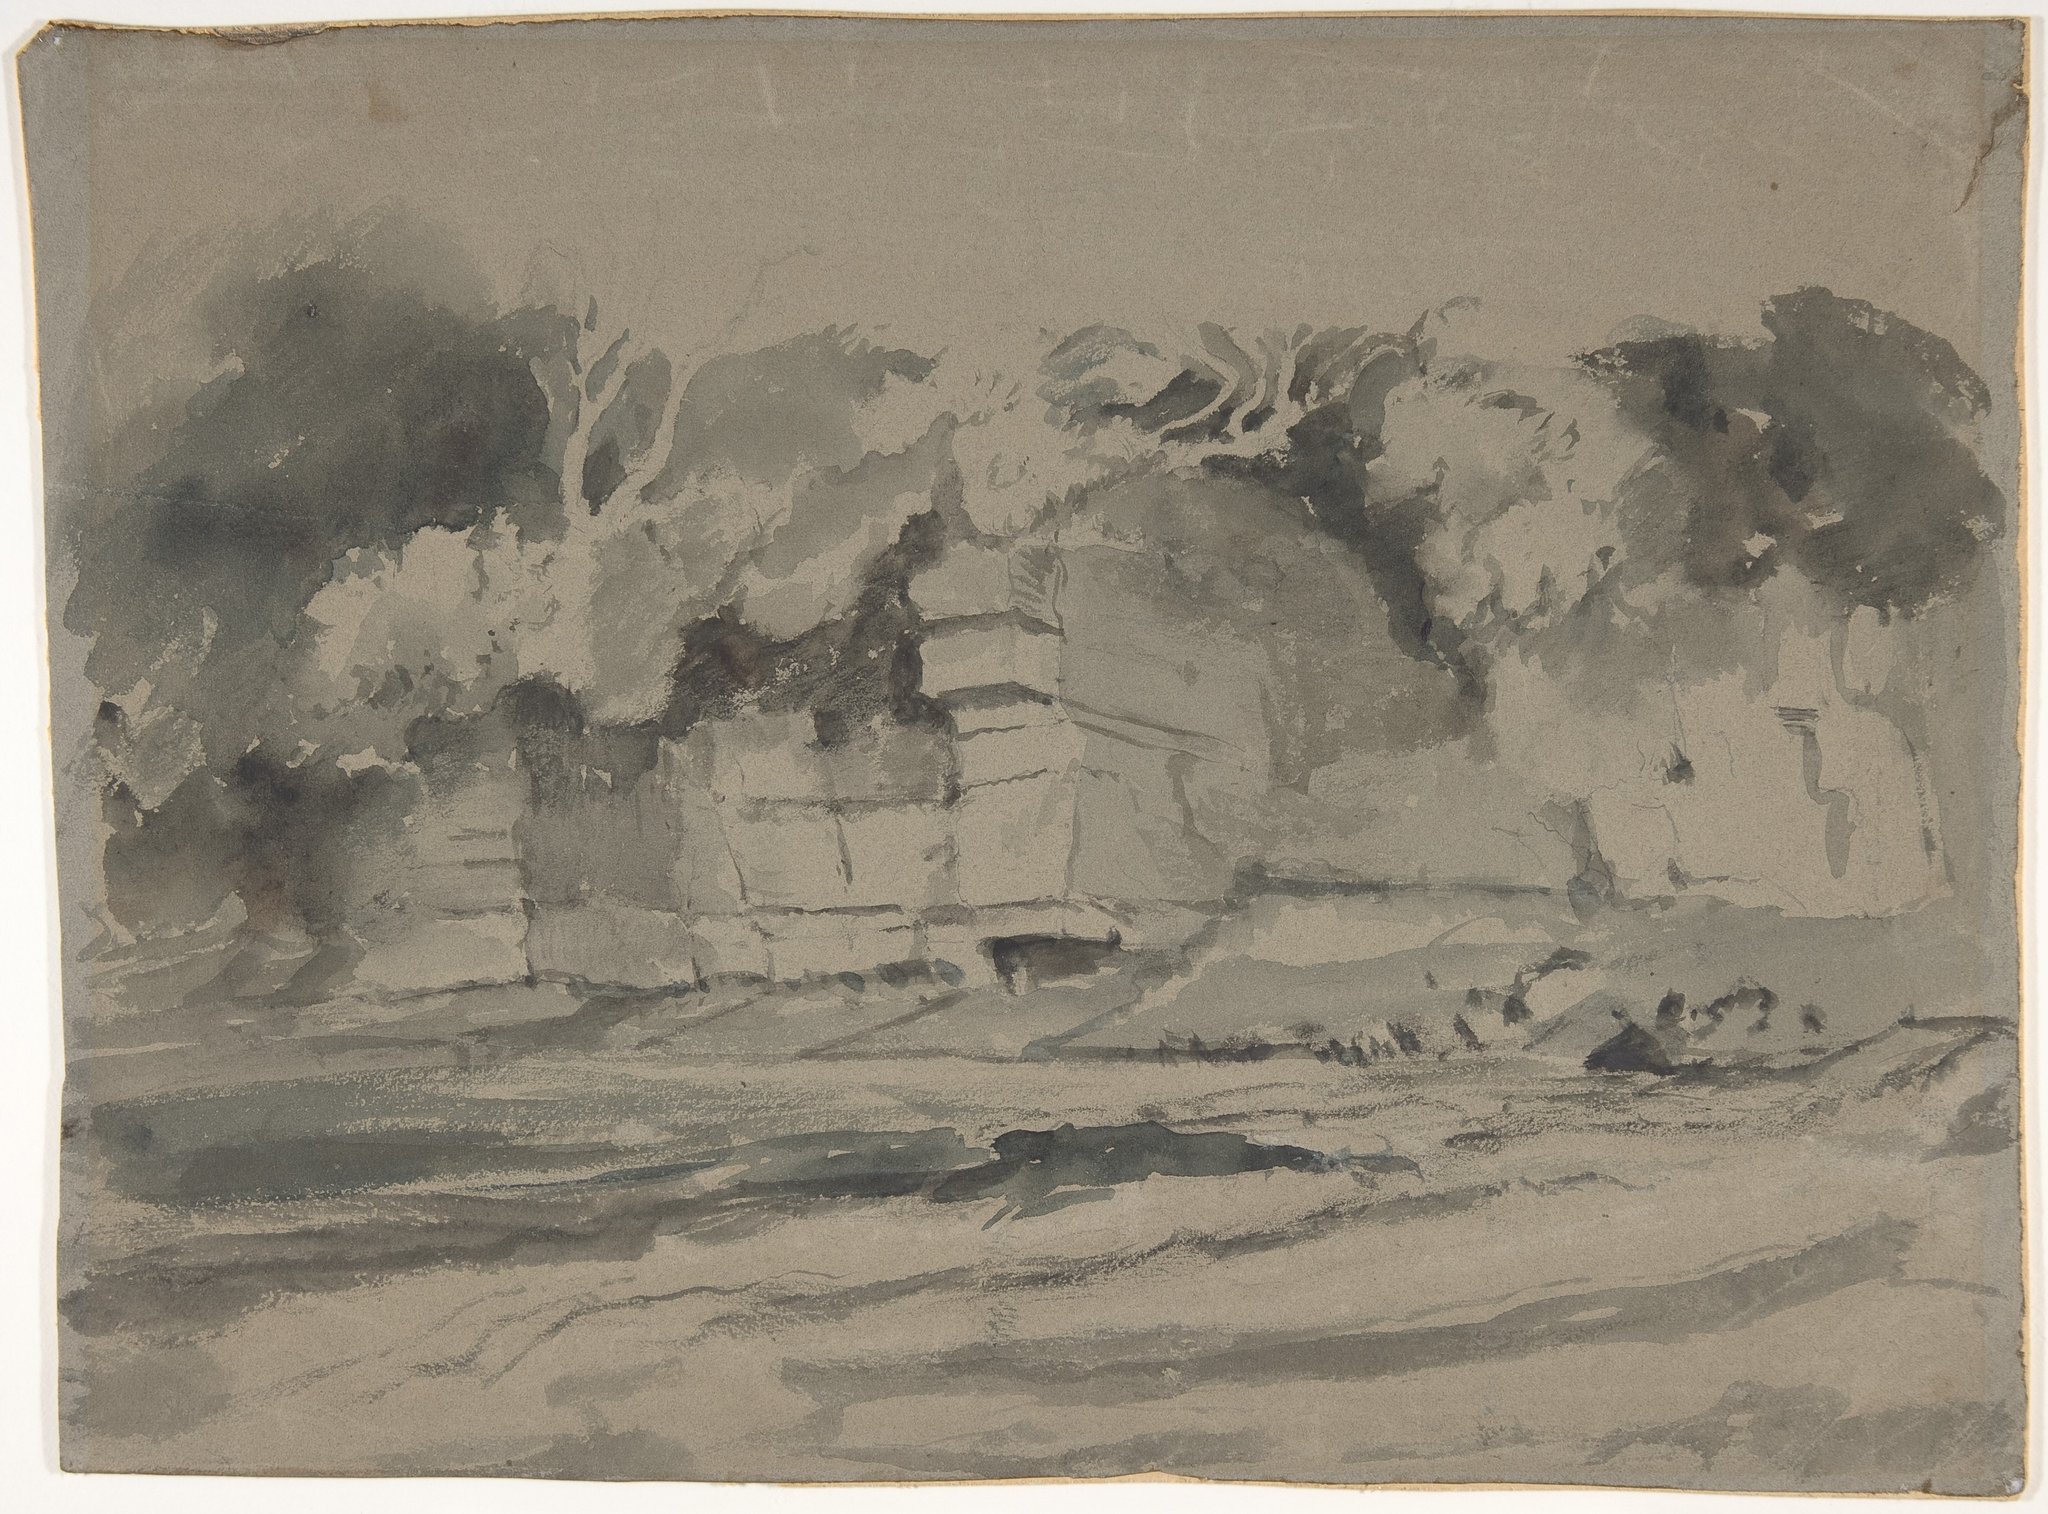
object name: drawing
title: Landscape with a rock wall, perhaps in Westmorland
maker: peter de wint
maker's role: artist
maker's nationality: british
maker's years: 1784-1849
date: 1800-1849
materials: paper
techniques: brush, wash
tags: landscapes